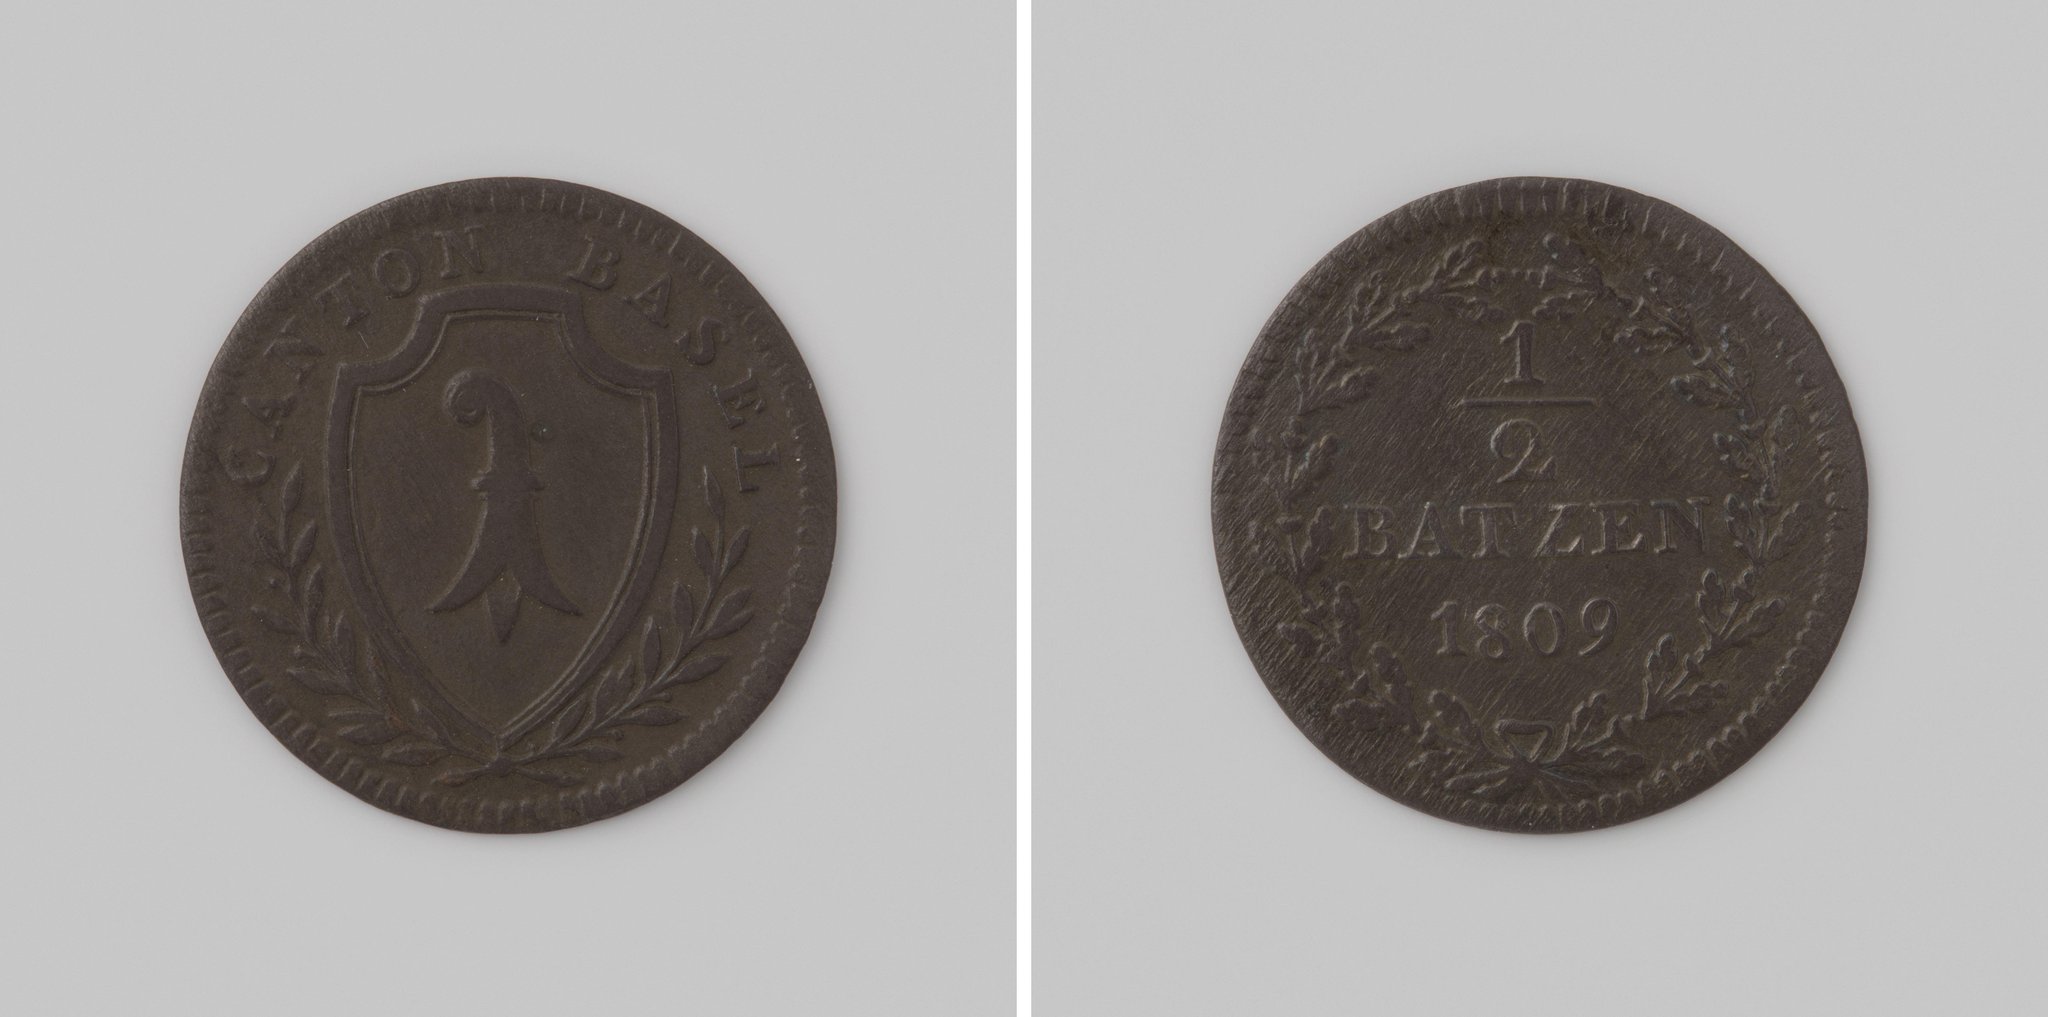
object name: coin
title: Kanton Bazel, ½ batzen, 1809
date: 1809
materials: silver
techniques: striking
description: Zilveren munt. Voorzijde: binnen twee samengebonden takken wapenschild. Keerzijde: binnen twee samengebonden takken in twee regels waarde-aanduiding, waaronder jaartal. Gladde rand.